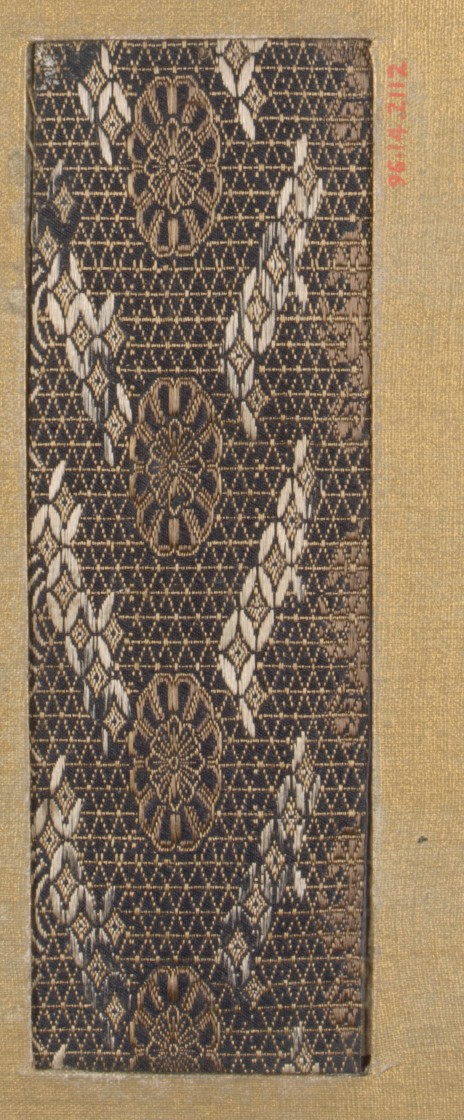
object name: piece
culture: japanese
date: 1701-1900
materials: silk